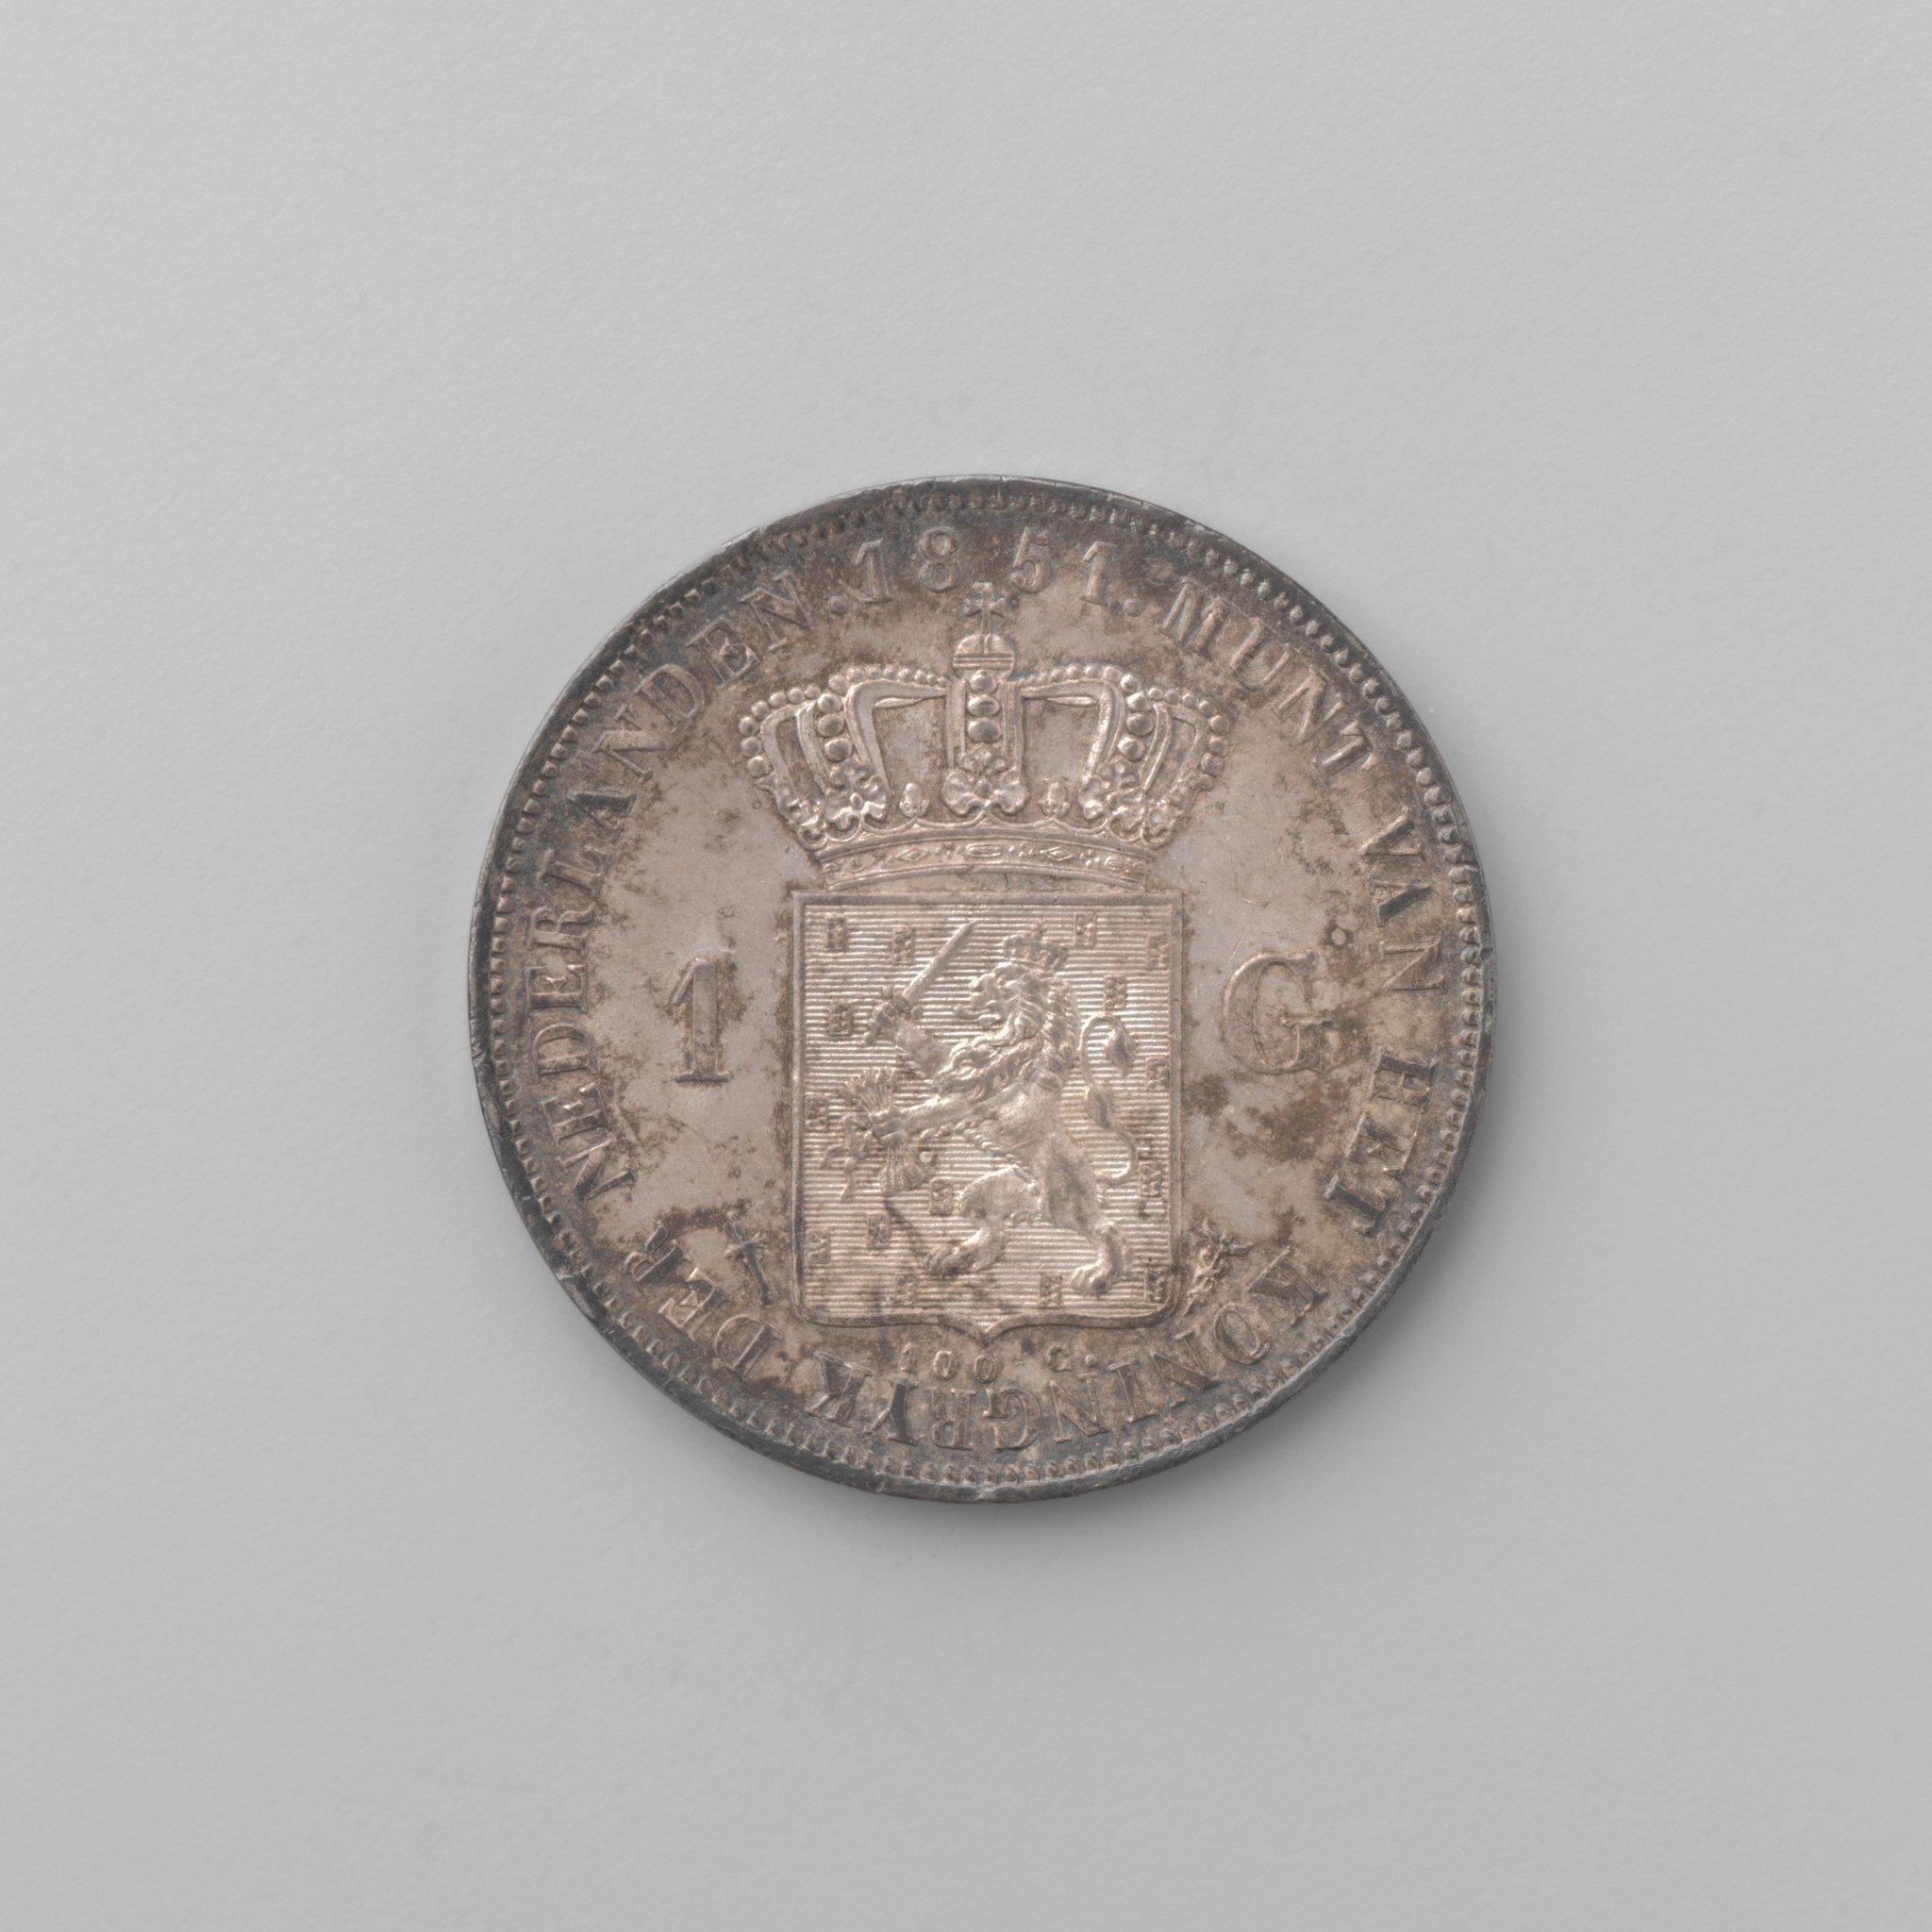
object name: coin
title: Nederland, gulden, 1851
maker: willem iii (koning der nederlanden)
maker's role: koning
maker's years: 1817-1890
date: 1851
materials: silver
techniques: striking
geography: utrecht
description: Zilveren munt. Voorzijde: borstbeeld naar rechts. Keerzijde: tussen waarde-aanduiding 1 G gekroond rijkswapenschild. Jaartal boven kroon. Randschrift.